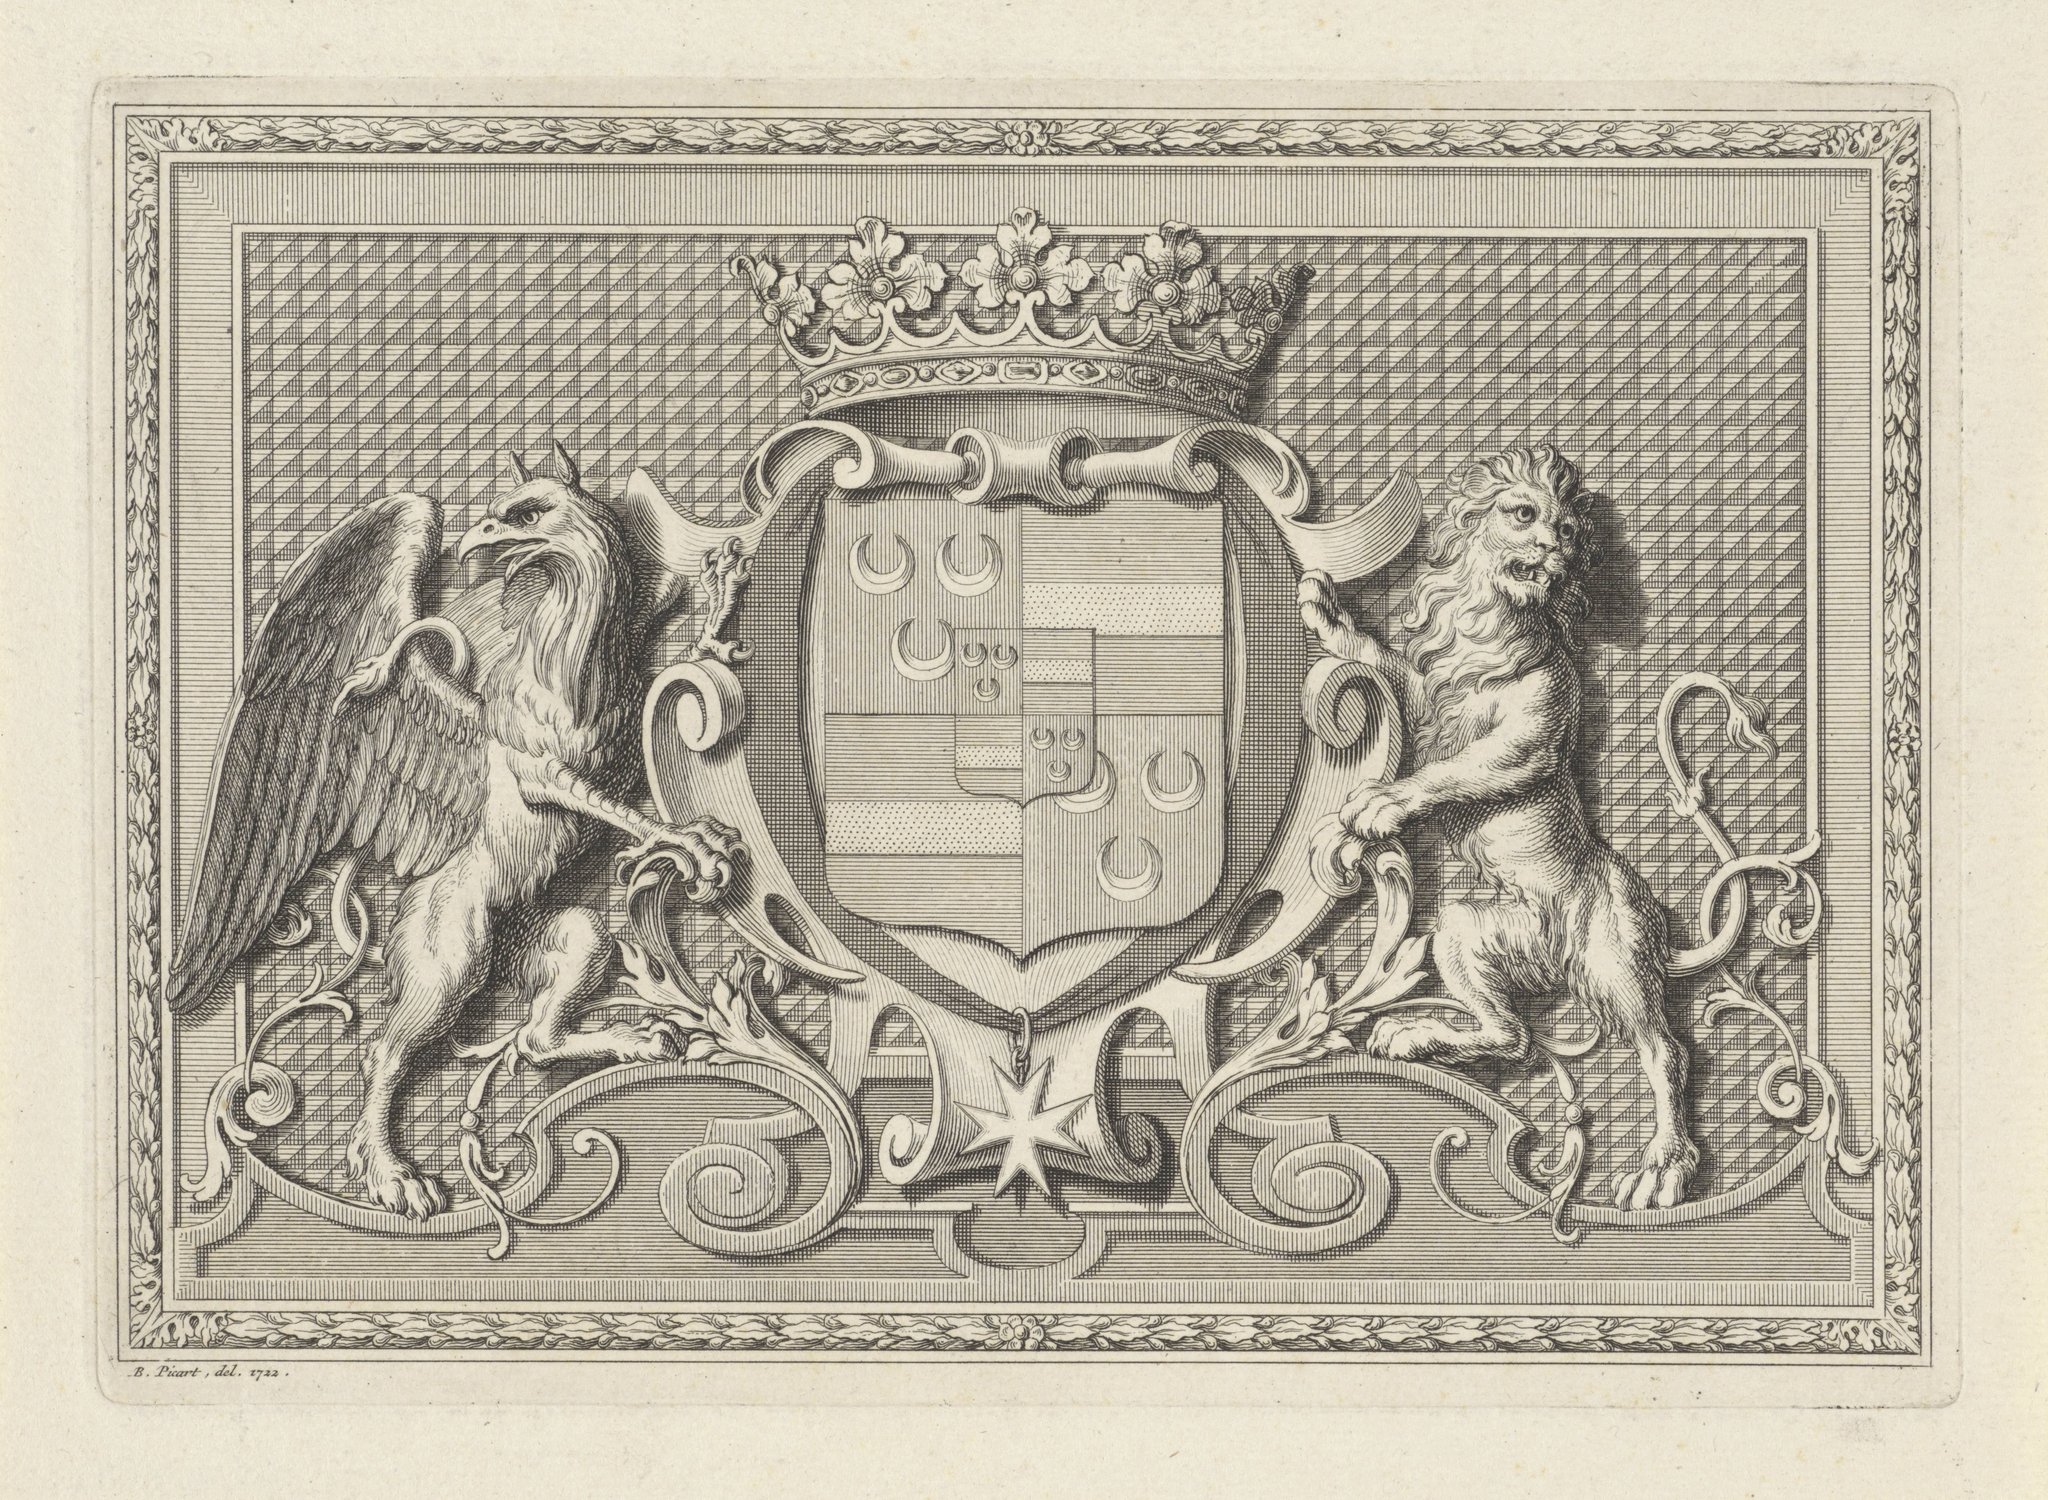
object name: print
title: Gekroond wapenschild gedragen door een hybride adelaar en een leeuw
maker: bernard picart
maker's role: draughtsman, print maker, publisher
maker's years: 1673-1733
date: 1722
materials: paper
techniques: engraving, etching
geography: amsterdam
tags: coat of arms (as symbol of the state, etc.), beasts of prey, predatory animals: lion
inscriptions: collector's mark: Lugt 2228